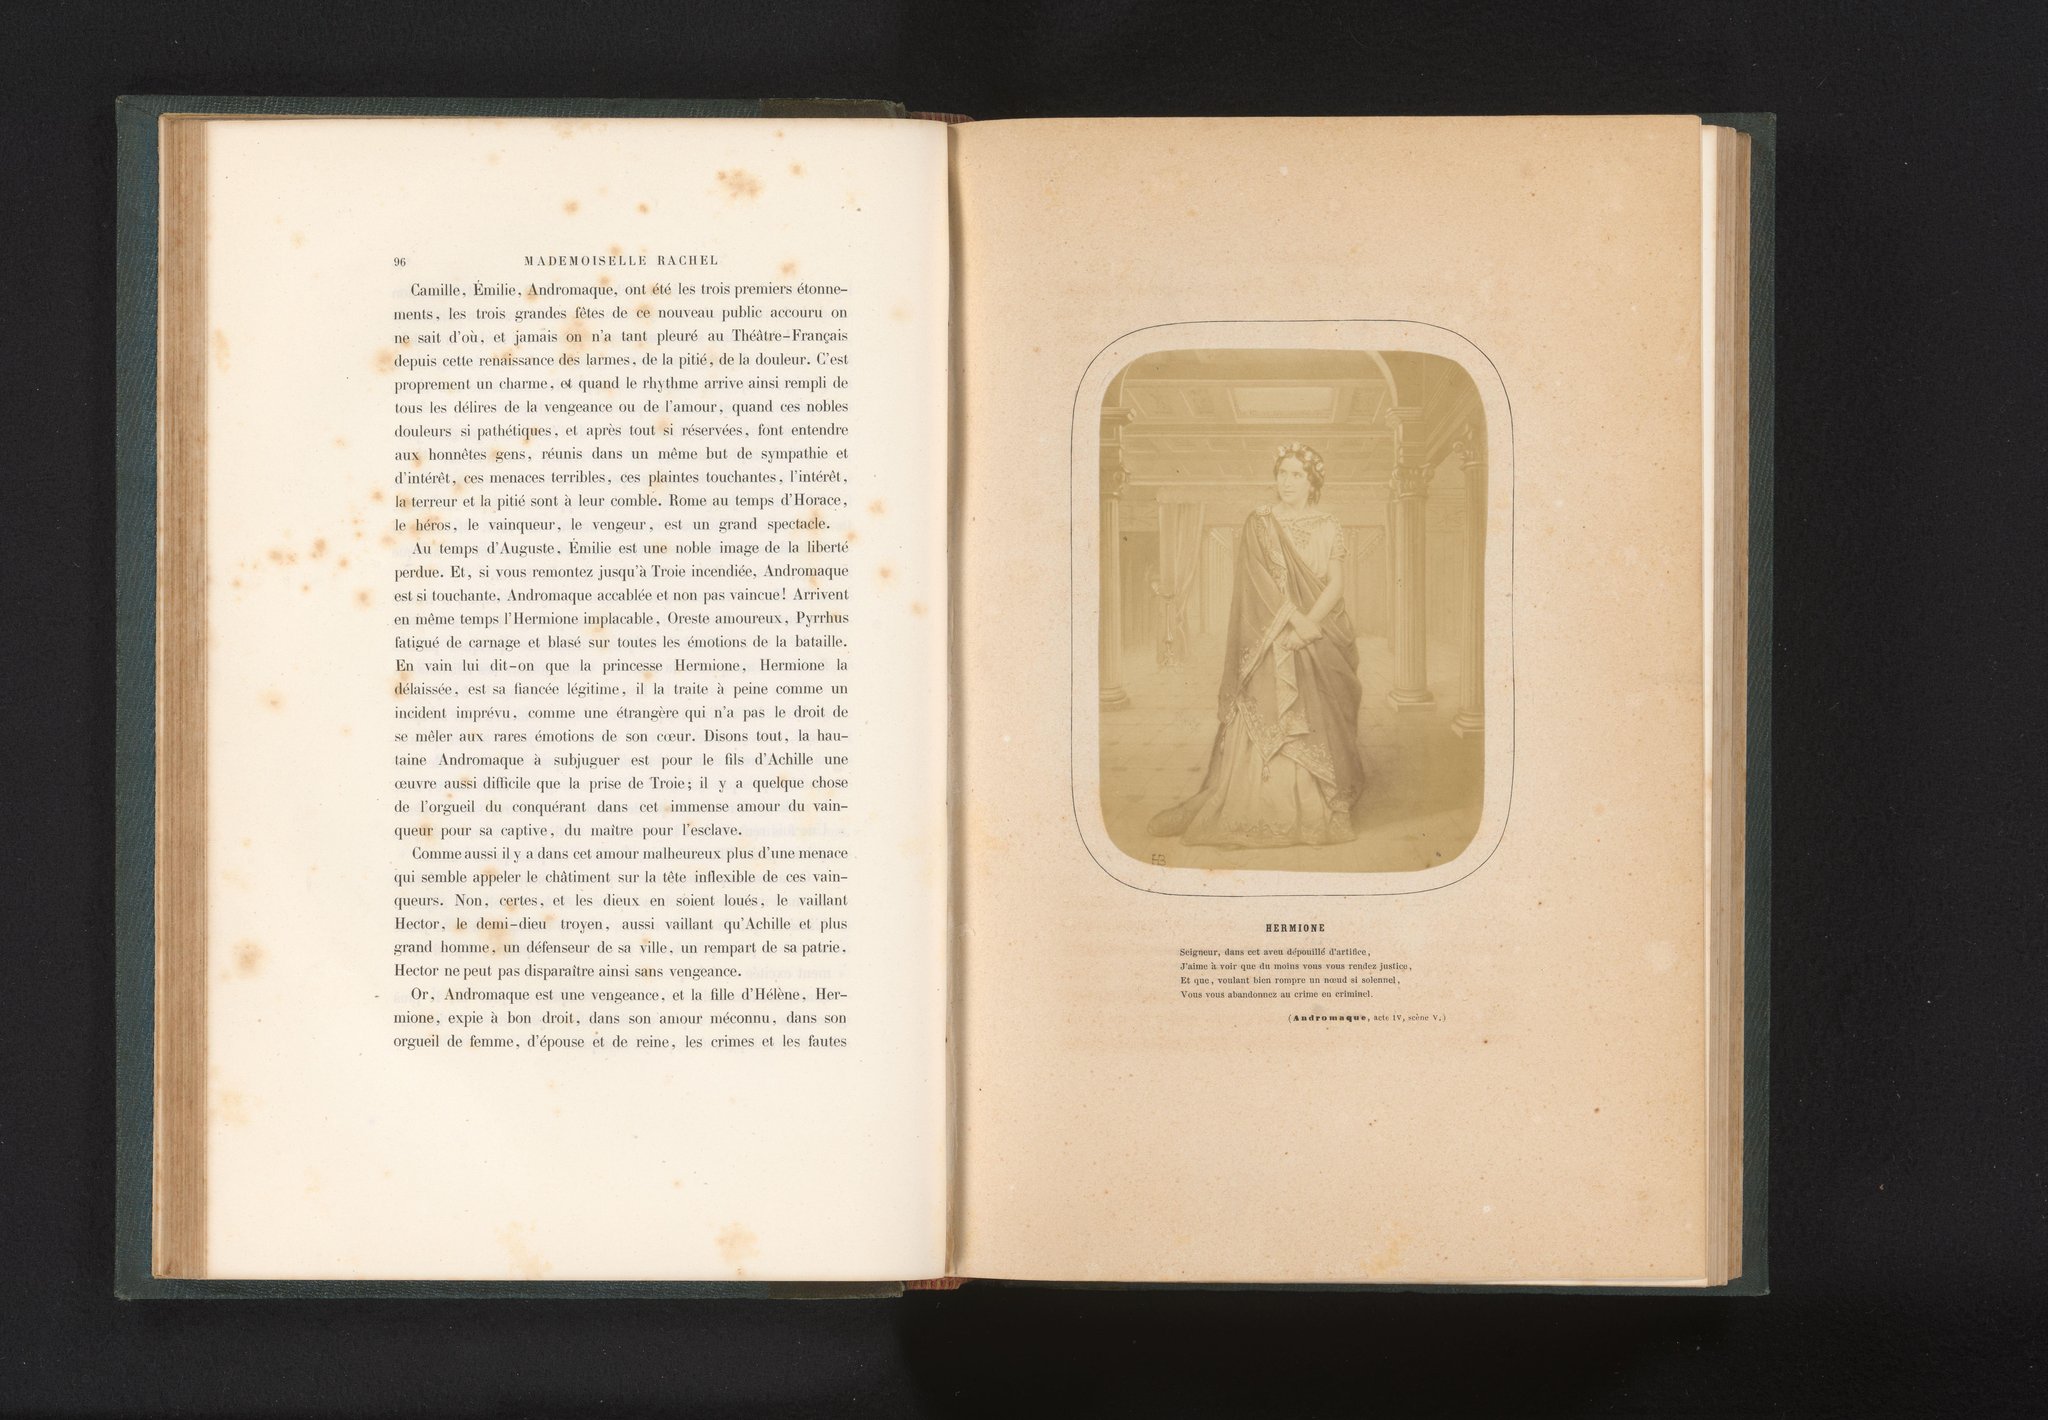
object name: reproduction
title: Hermione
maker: henri de la blanchère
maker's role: fotograaf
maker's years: 1821-1880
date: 1854-1859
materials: paper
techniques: albumen print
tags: actress (on the stage), picture, painting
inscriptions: inscription: ‘Seigneur, dans cet aveu dépouillé d'artifice,/ J'aime à voir que du moins vous vous rendez justice,/ Et que, voulant bien rompre un noeud si solennel,/ VOus vous abandonnez au crime en criminel./ (Andromaque, acte IV, scène V.)’